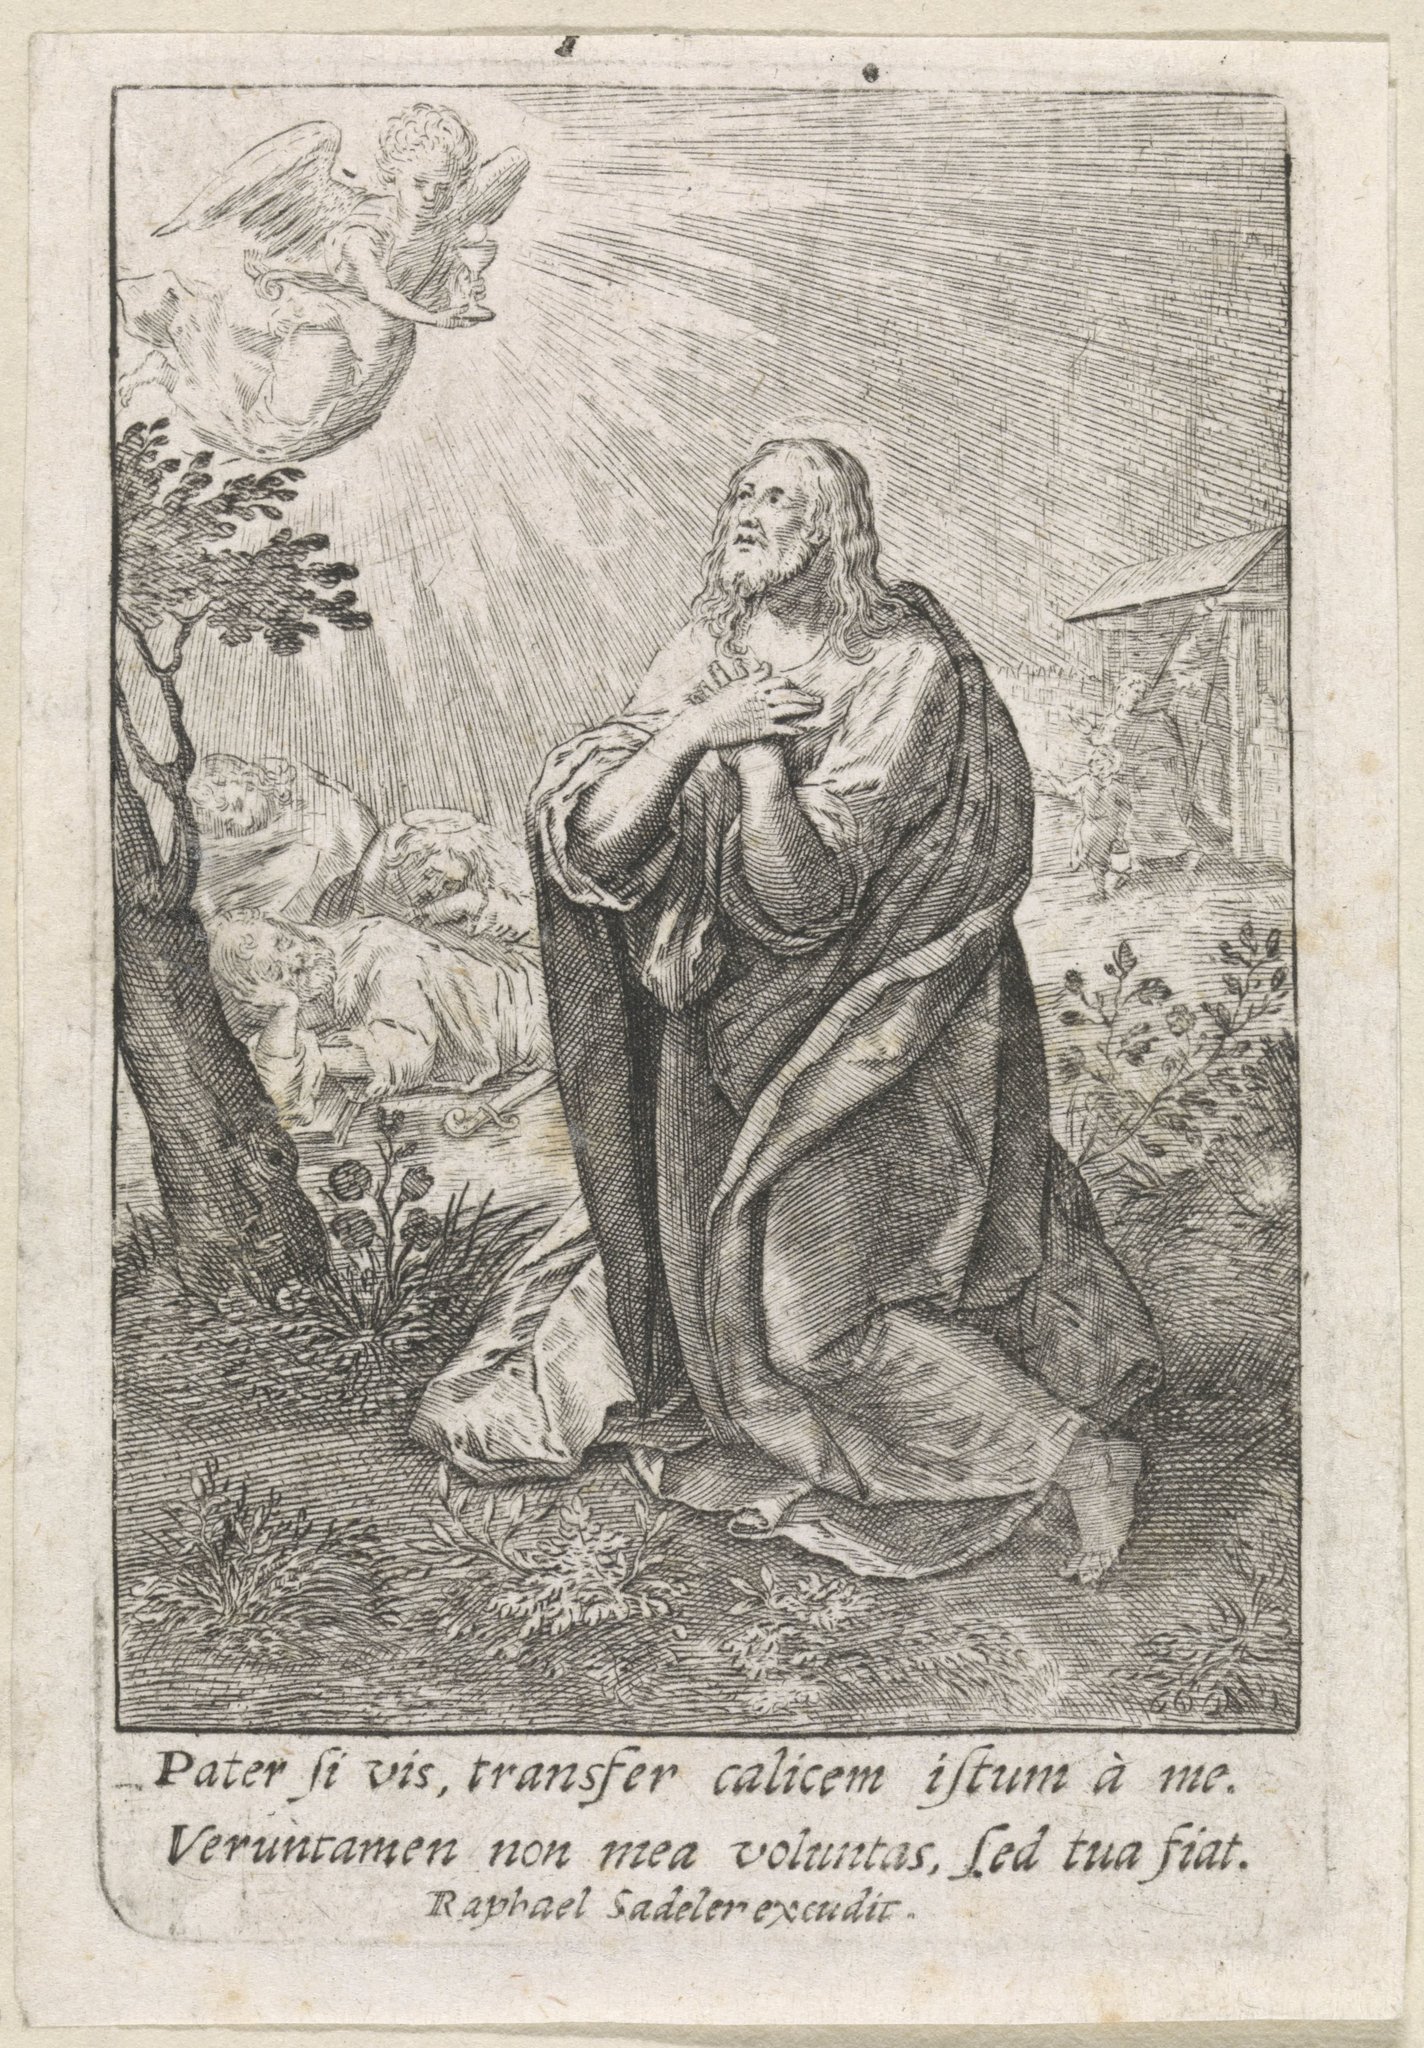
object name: print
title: Christus in de hof van Getsemane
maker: anna bergia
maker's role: publisher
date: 1617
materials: paper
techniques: engraving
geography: munich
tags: agony of christ: to comfort him one or more angels appear to christ with chalice and/or cross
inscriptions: collector's mark: Lugt 240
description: Prent uit: Ceschi, Matia. Otium spirituale mellifluarum precationum. München: Anna Bergia en Raphaël Sadeler (I) of (II), 1617.